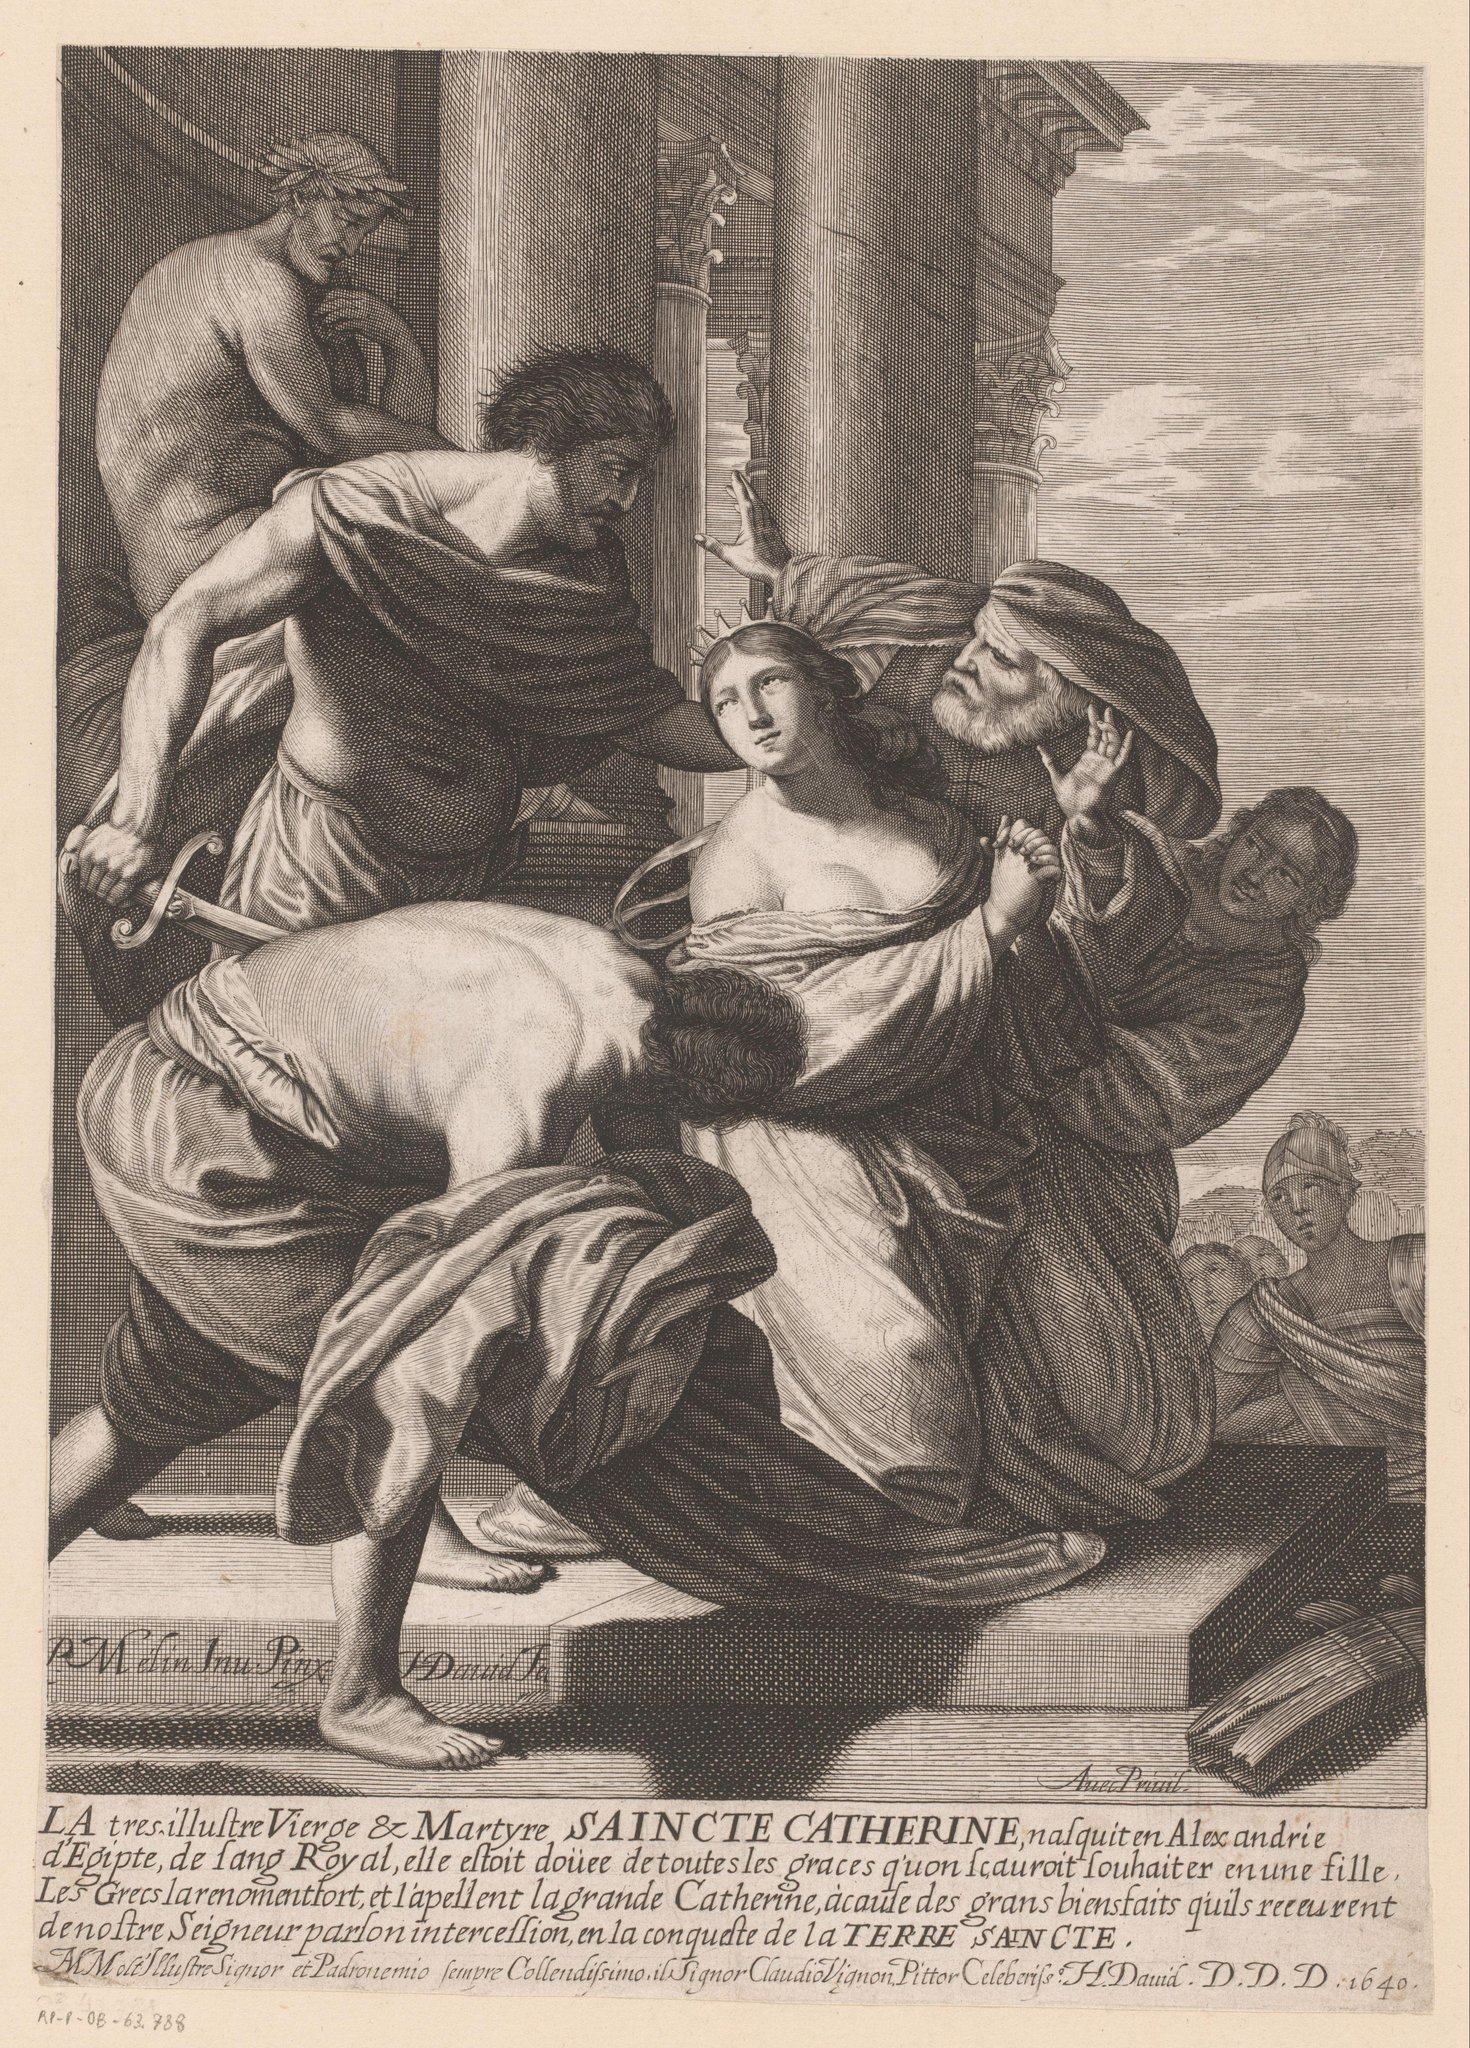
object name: print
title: Catharina van Alexandrië met haar beulen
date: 1640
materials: paper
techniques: engraving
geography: france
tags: martyrdom, suffering, misfortune, death of st. catherine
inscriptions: collector's mark: Lugt 240